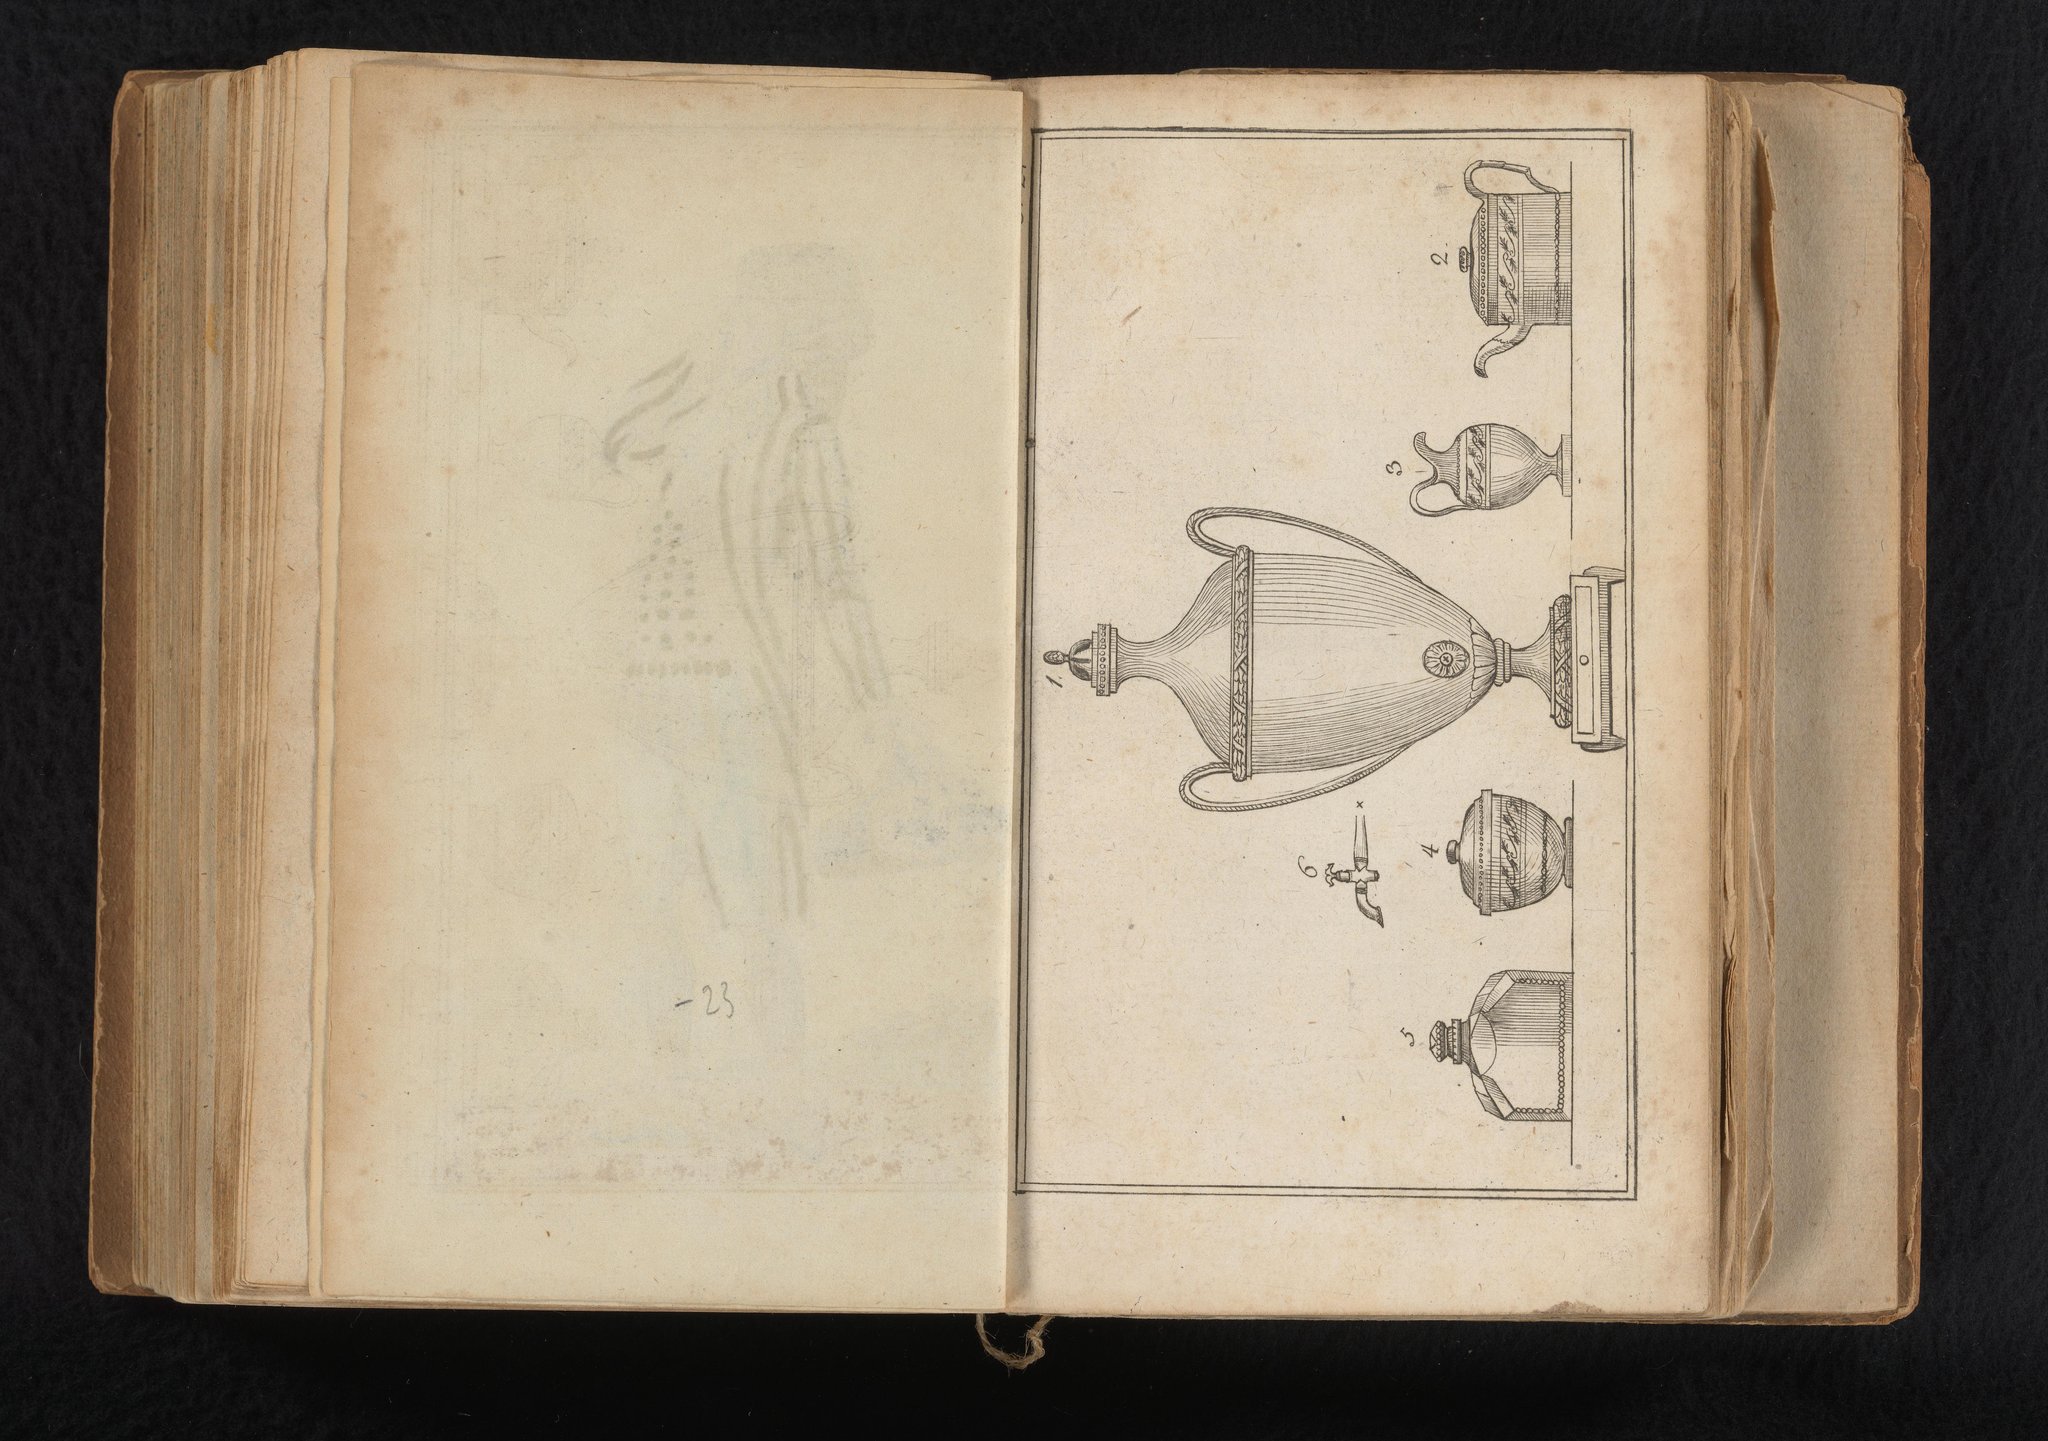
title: Journal des Luxus und der Moden 1788, Band III, T.24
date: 1788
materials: paper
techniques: etching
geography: weimar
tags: fashion plates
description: Prent uit het modetijdschrift Journal des Luxus und der Moden, uitgegeven door Friedrich Justin Bertuch en Georg Melchior Kraus, Weimar, 1786-1826.